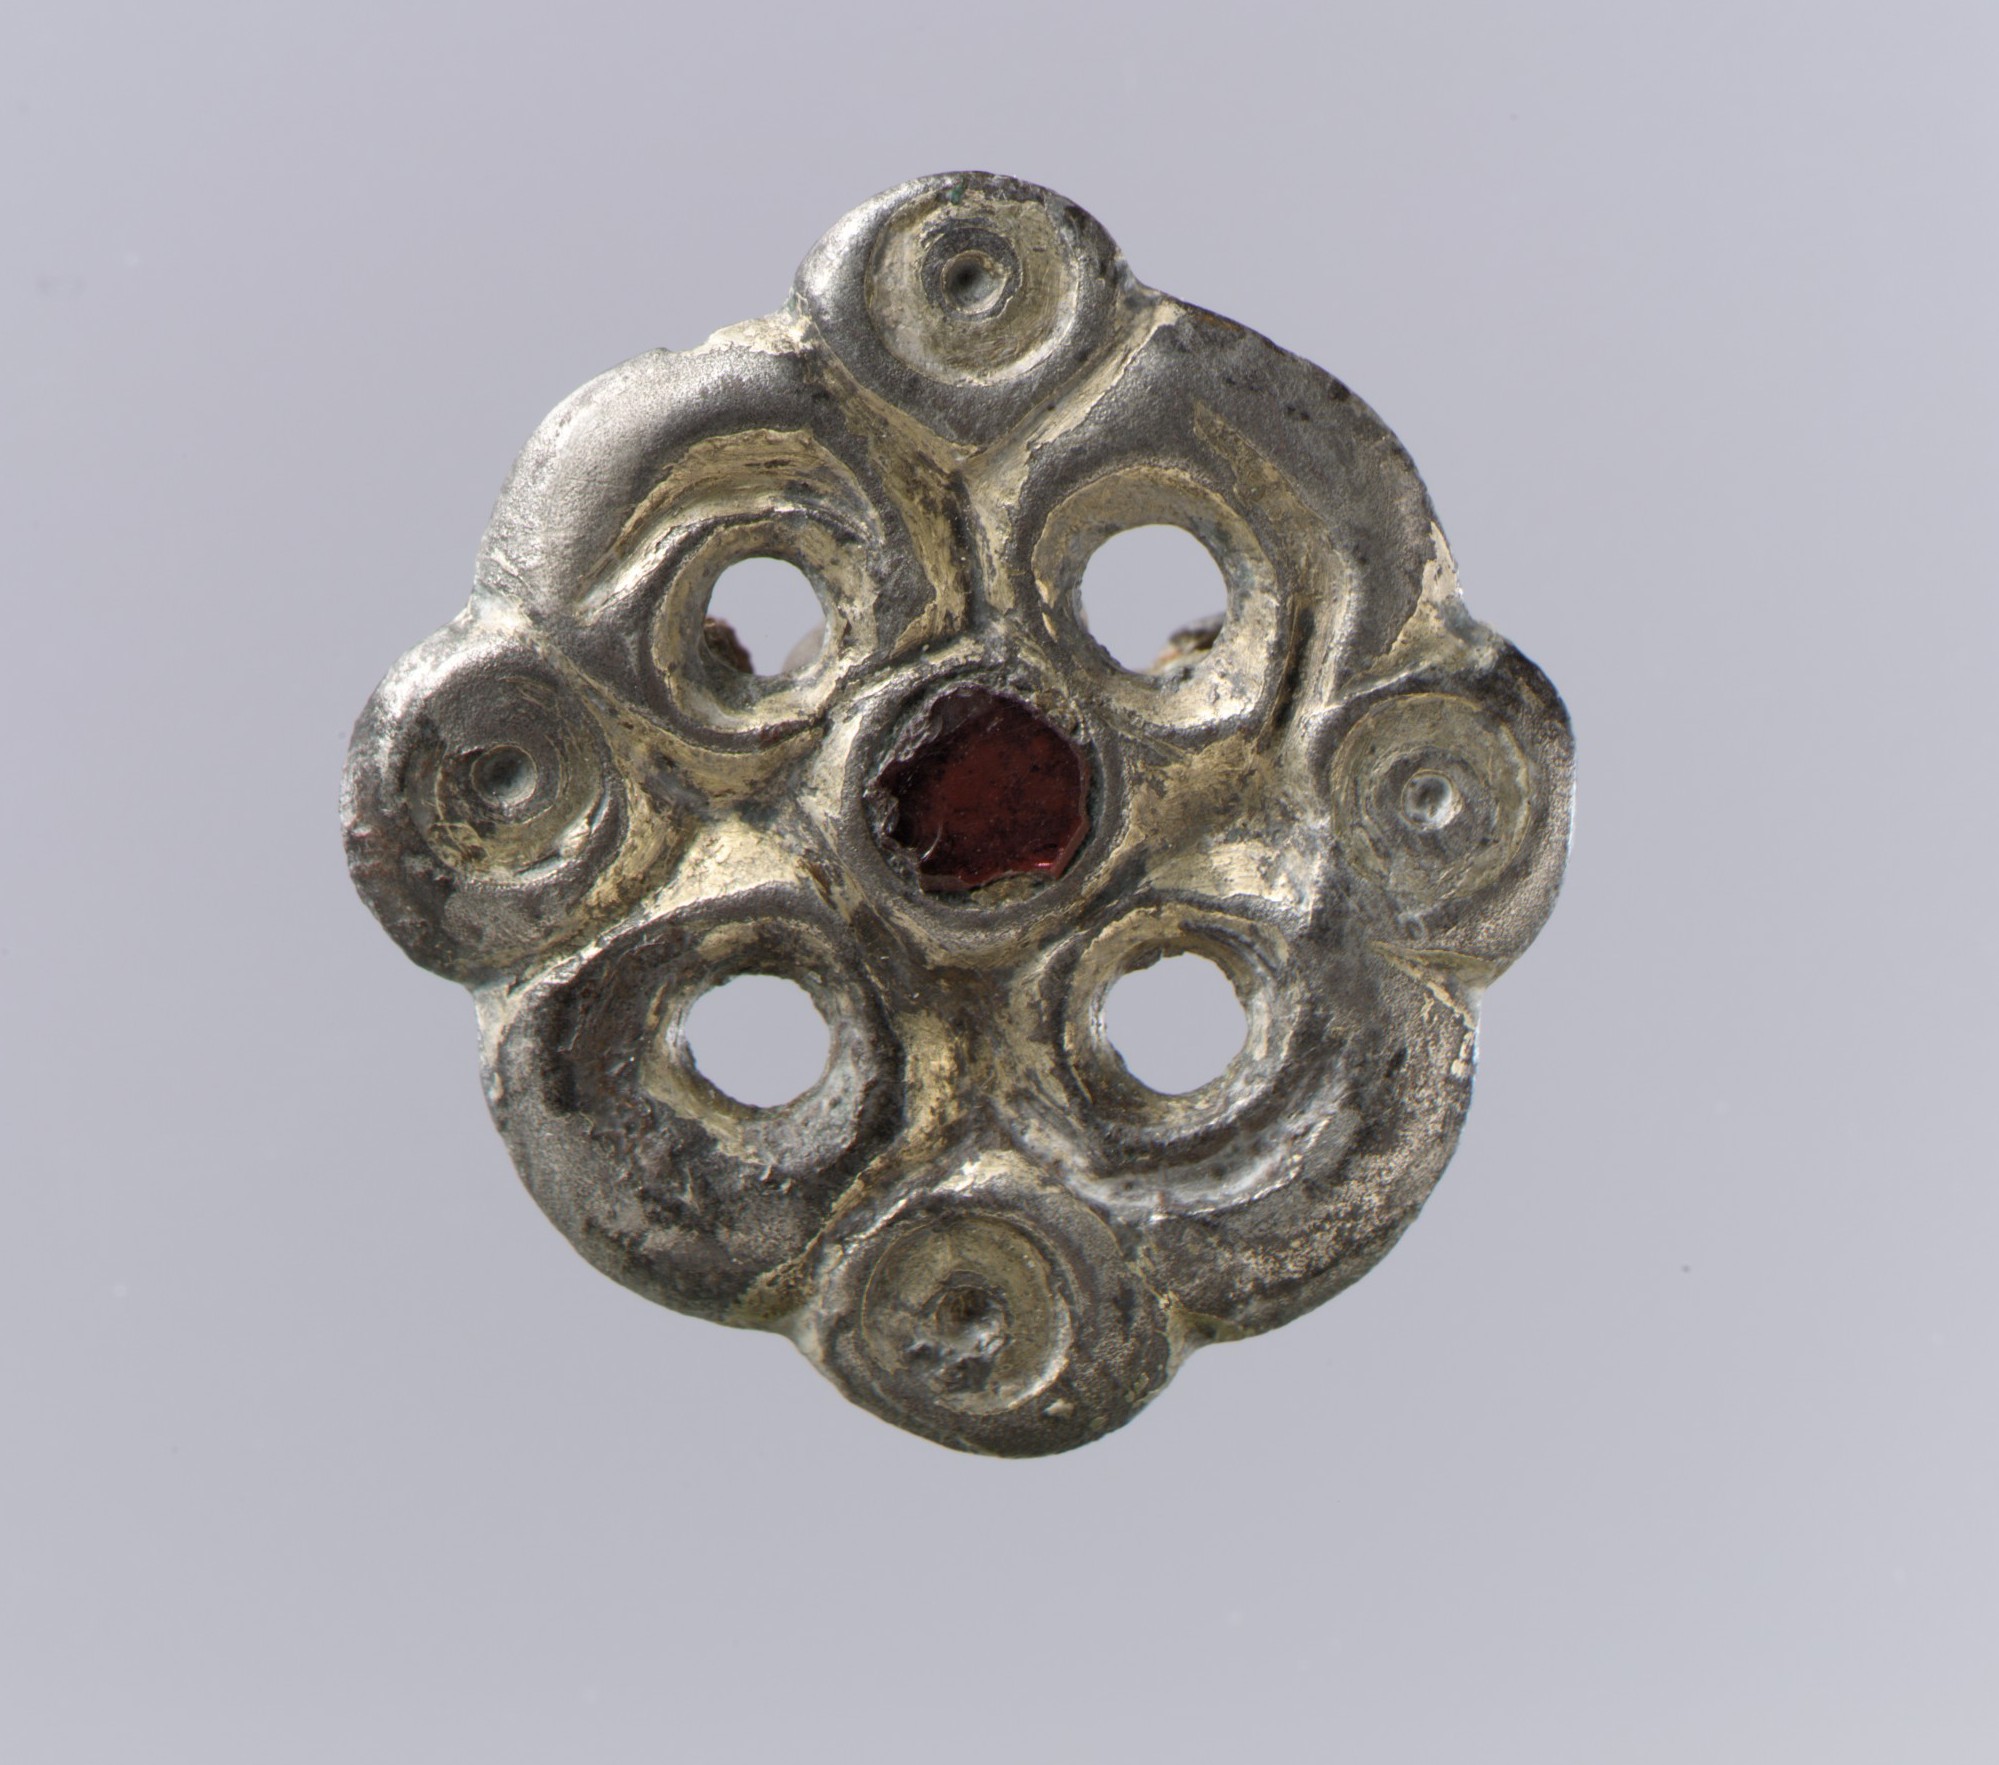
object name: brooch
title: Openwork Rosette Brooch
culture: frankish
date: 501-600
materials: gemstone, iron, silver, silver gilt